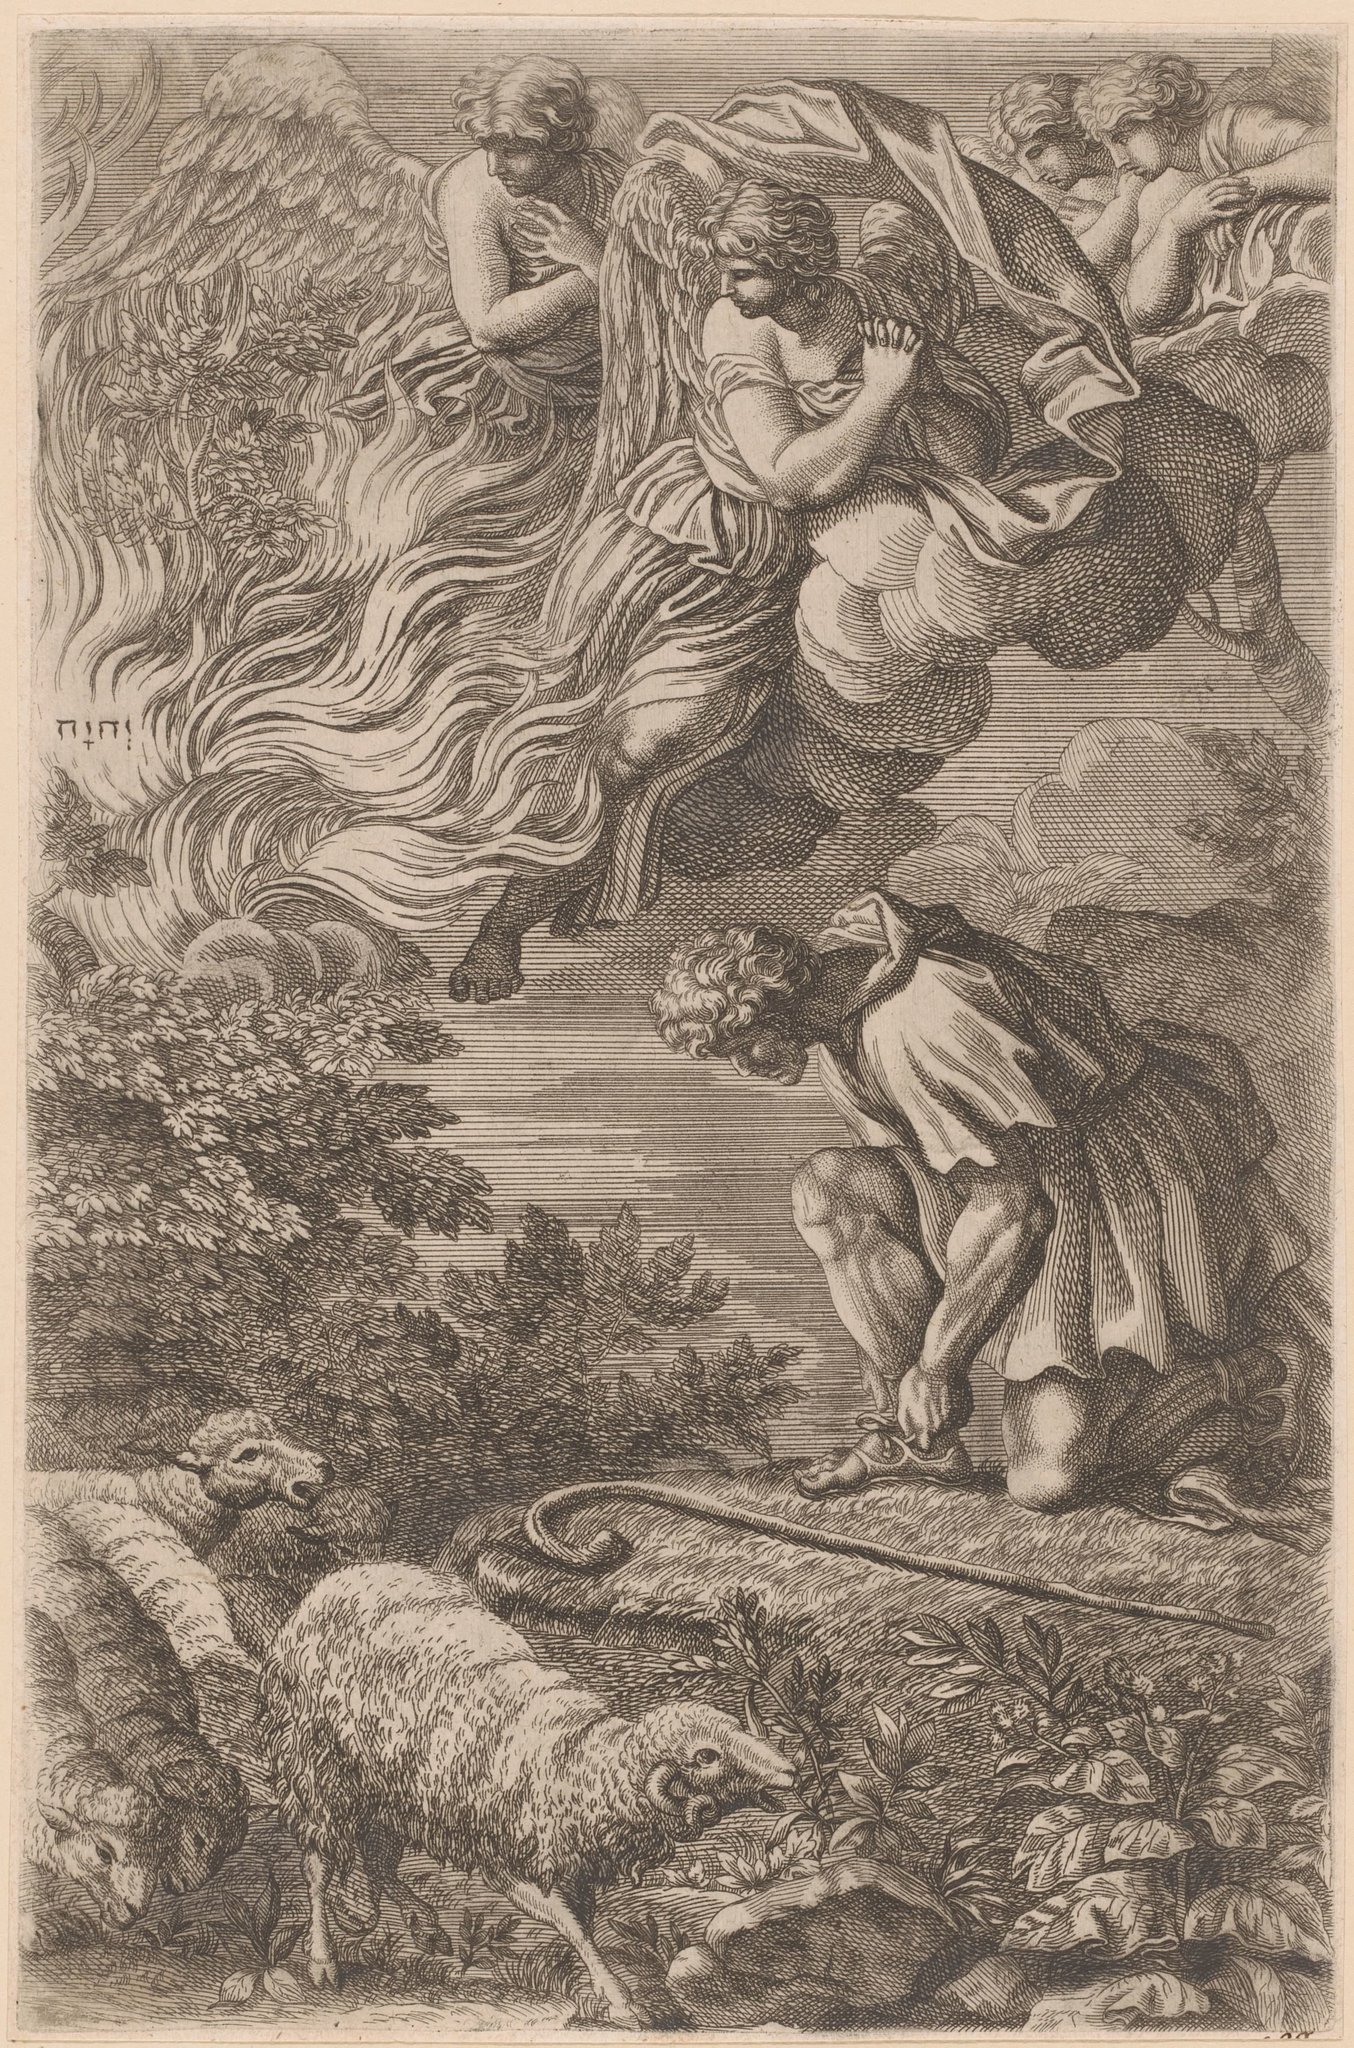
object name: print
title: Mozes en de brandende braamstruik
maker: Anonymous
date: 1600-1660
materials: paper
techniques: etching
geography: france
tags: moses, kneeling before the bush and hiding his face, listens to god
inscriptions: collector's mark: Lugt 240